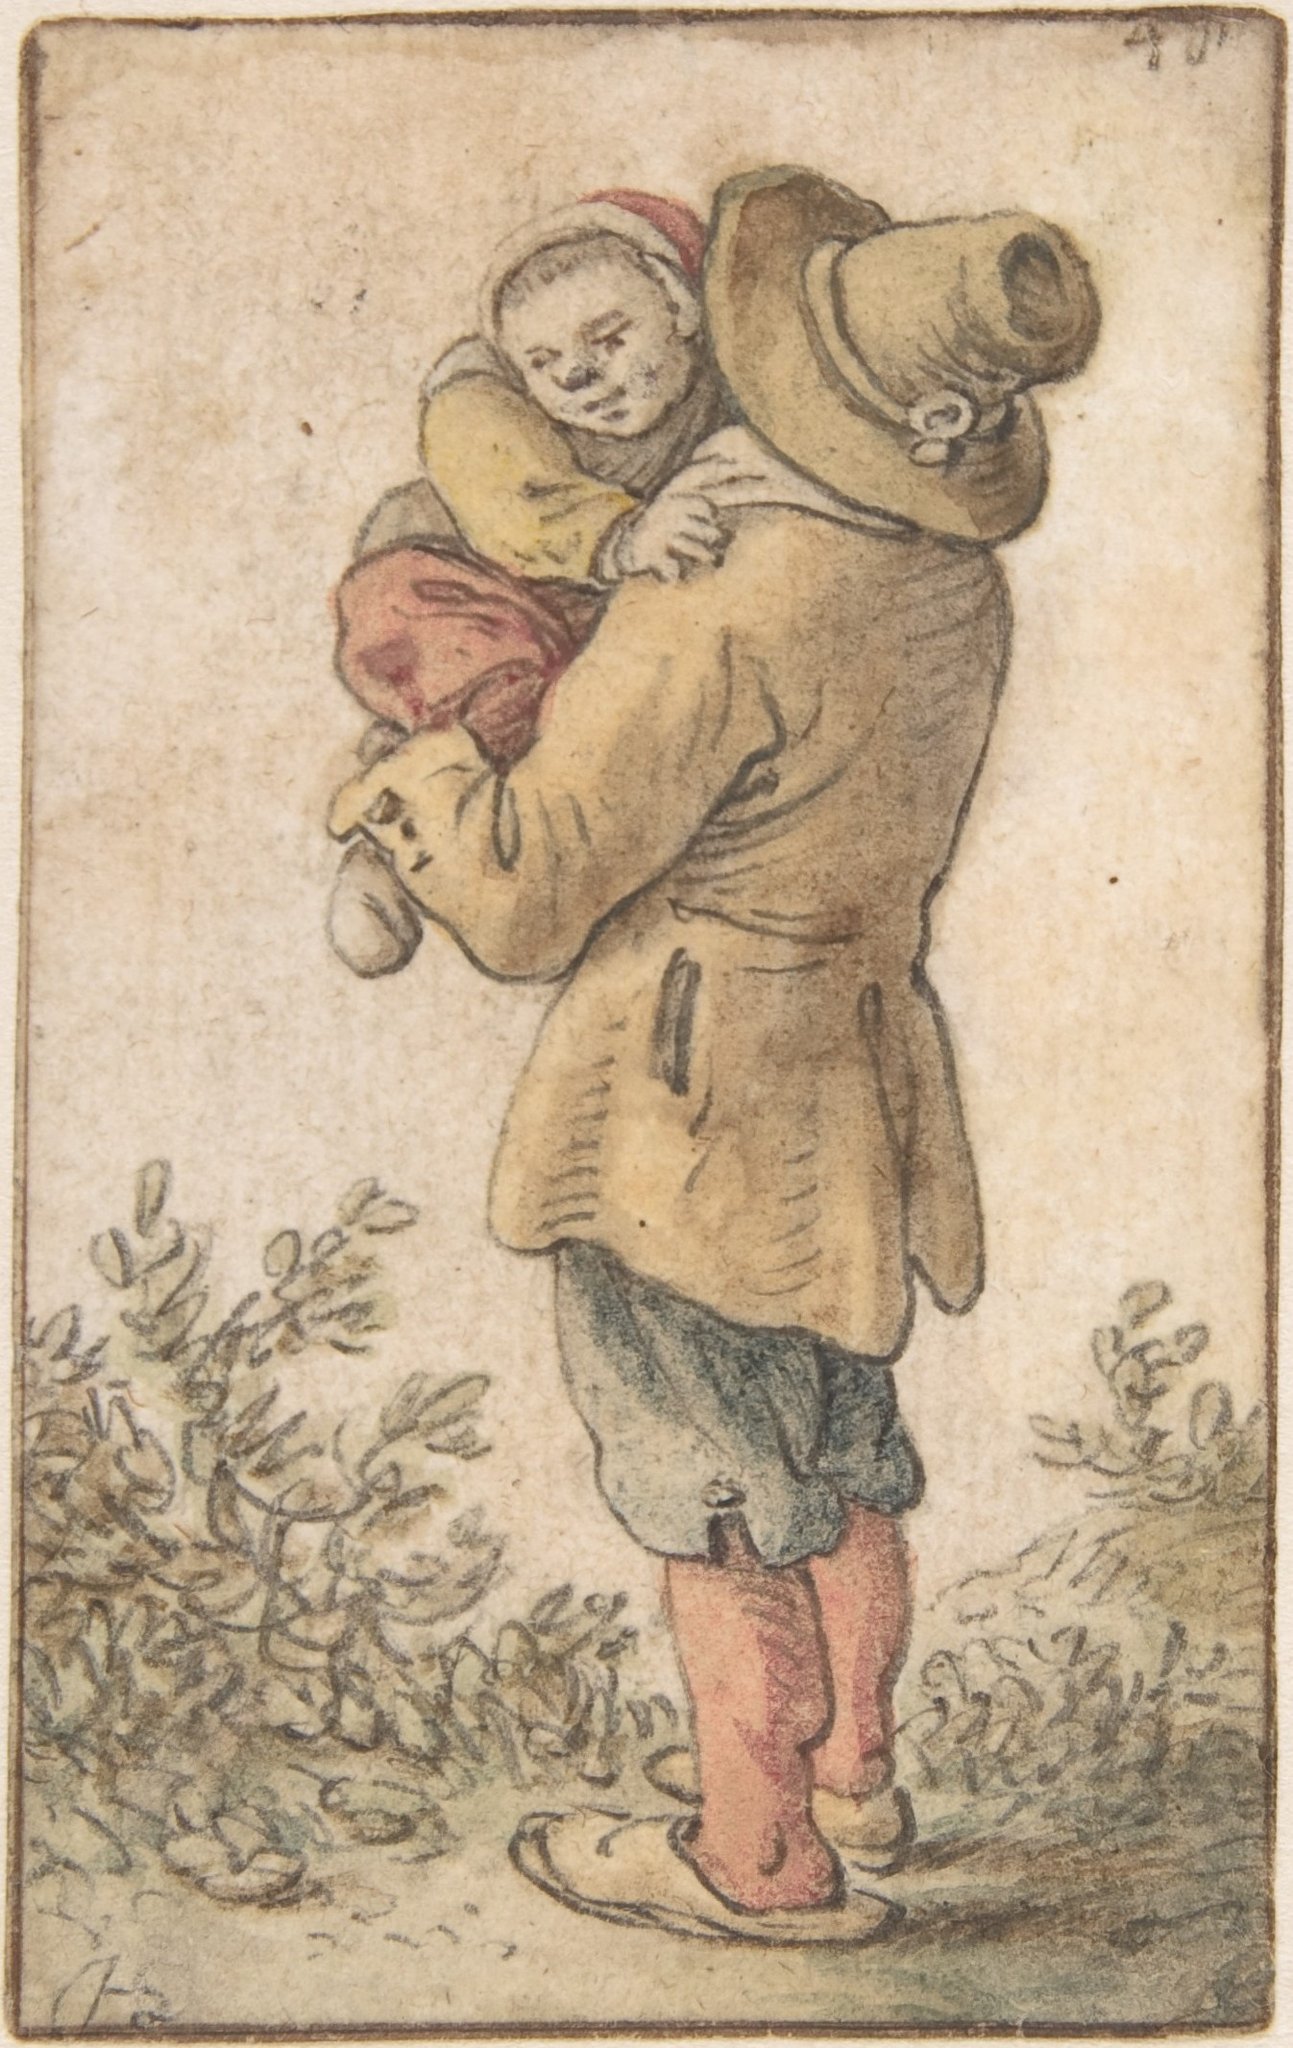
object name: drawing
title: Peasant with Child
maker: herman saftleven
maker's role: artist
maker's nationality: dutch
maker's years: 1609-1685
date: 1601-1700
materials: chalk, watercolor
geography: germany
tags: children,men